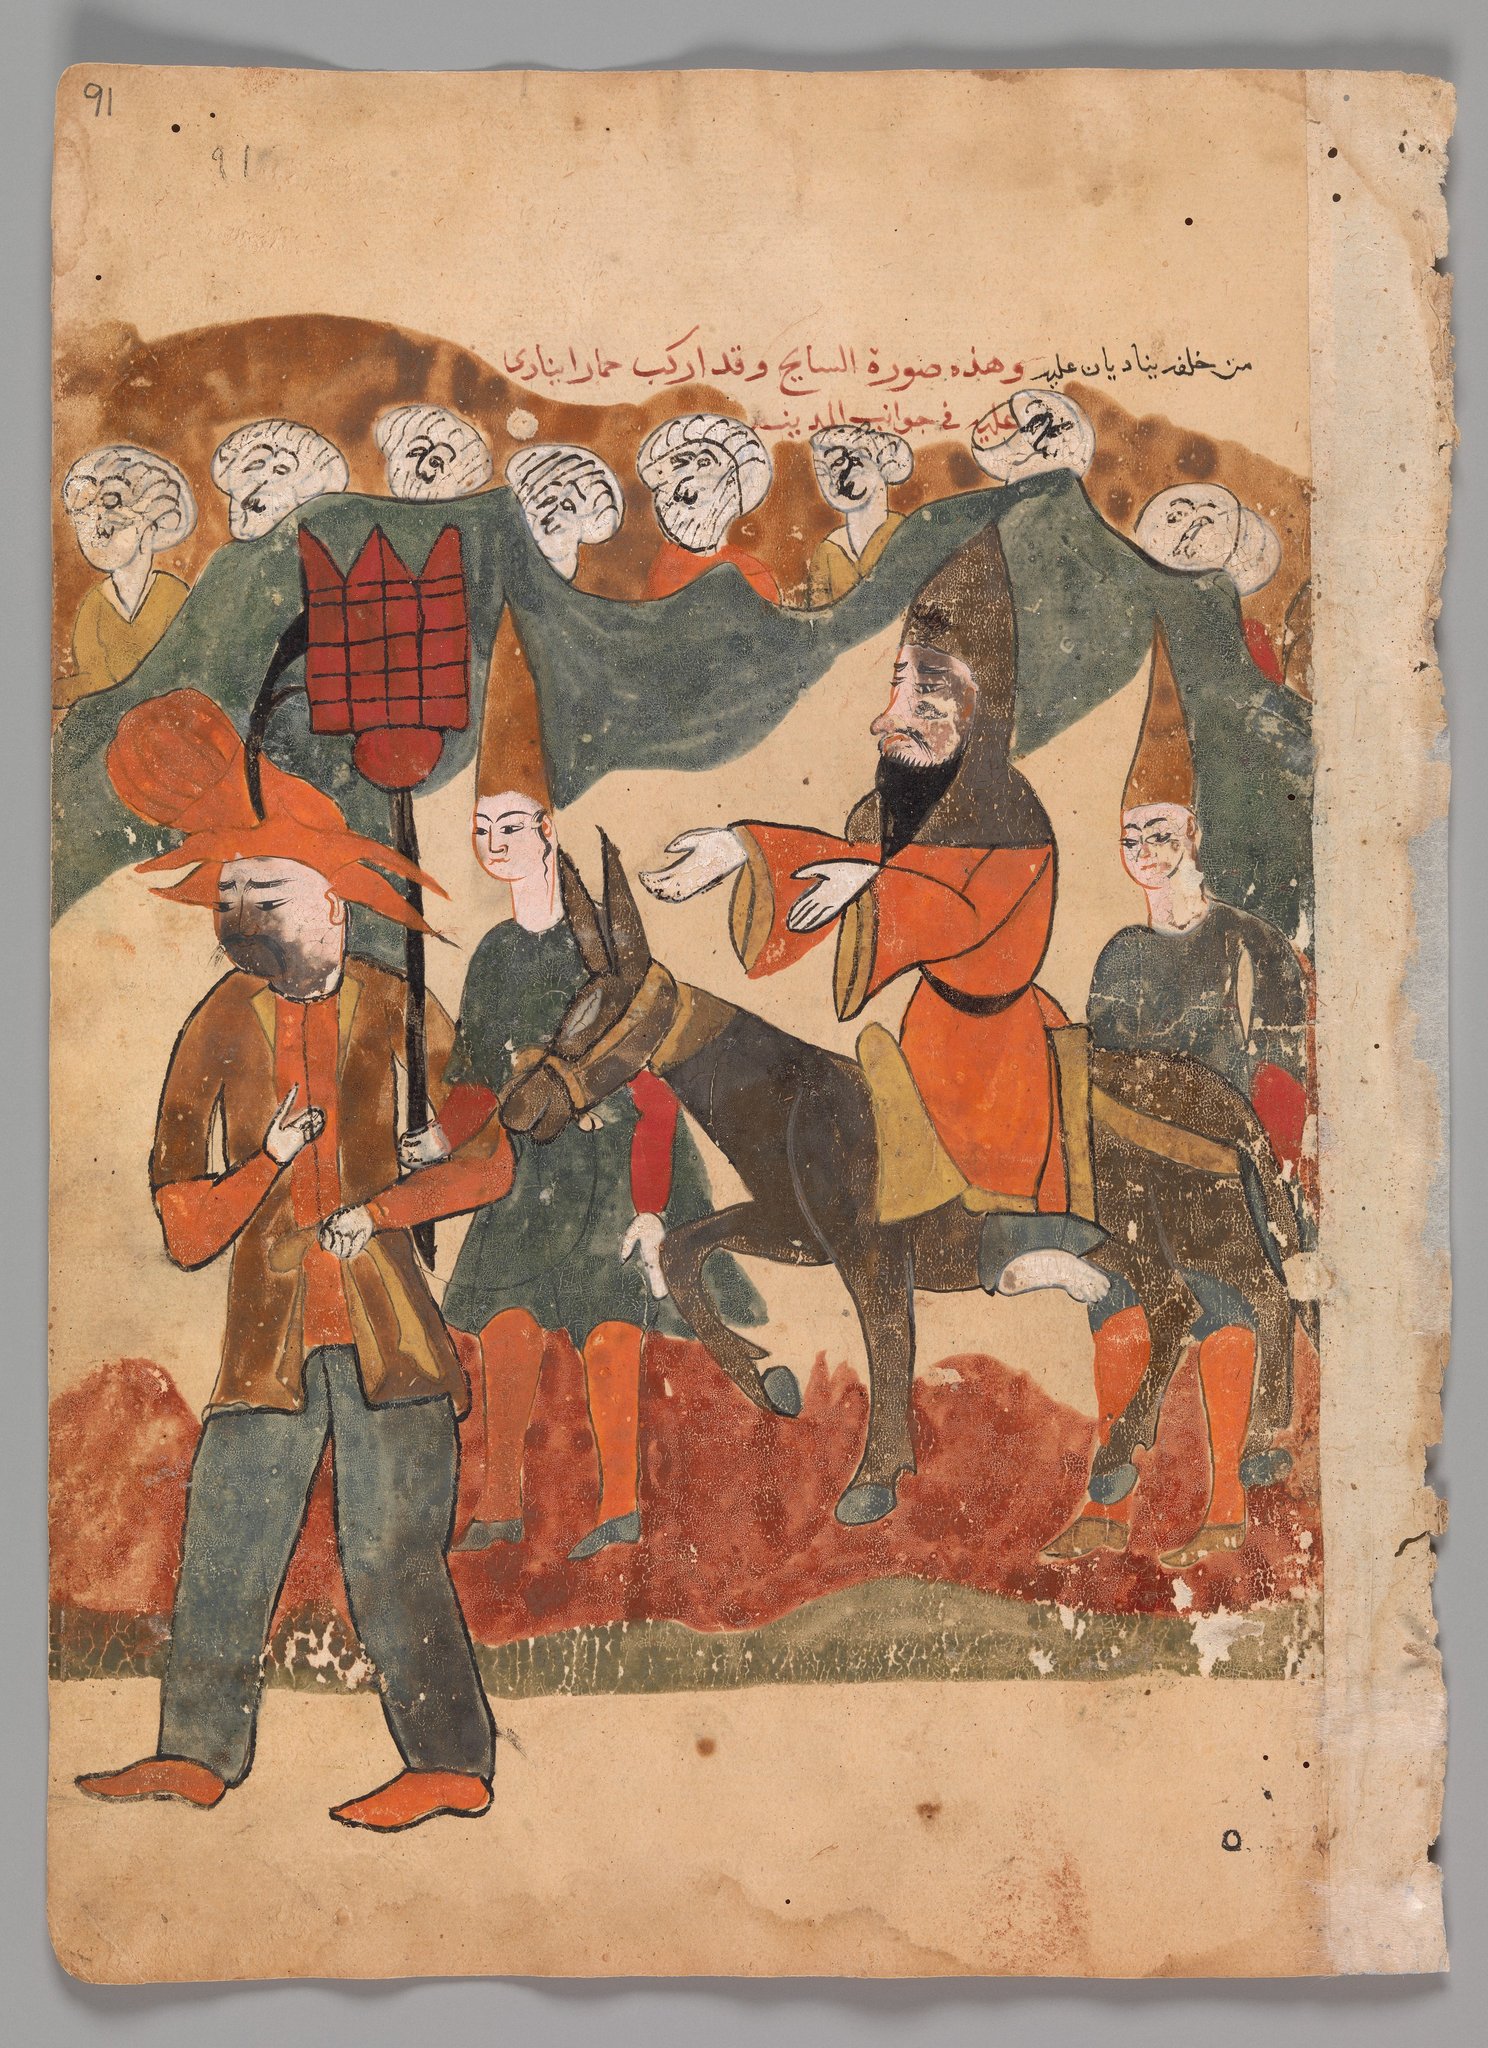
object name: folio from an illustrated manuscript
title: "The Discredited Ascetic Being Paraded Through the Town on a Donkey", Folio from a Kalila wa Dimna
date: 1526-1550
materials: ink, paper, watercolor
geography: india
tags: men,donkeys